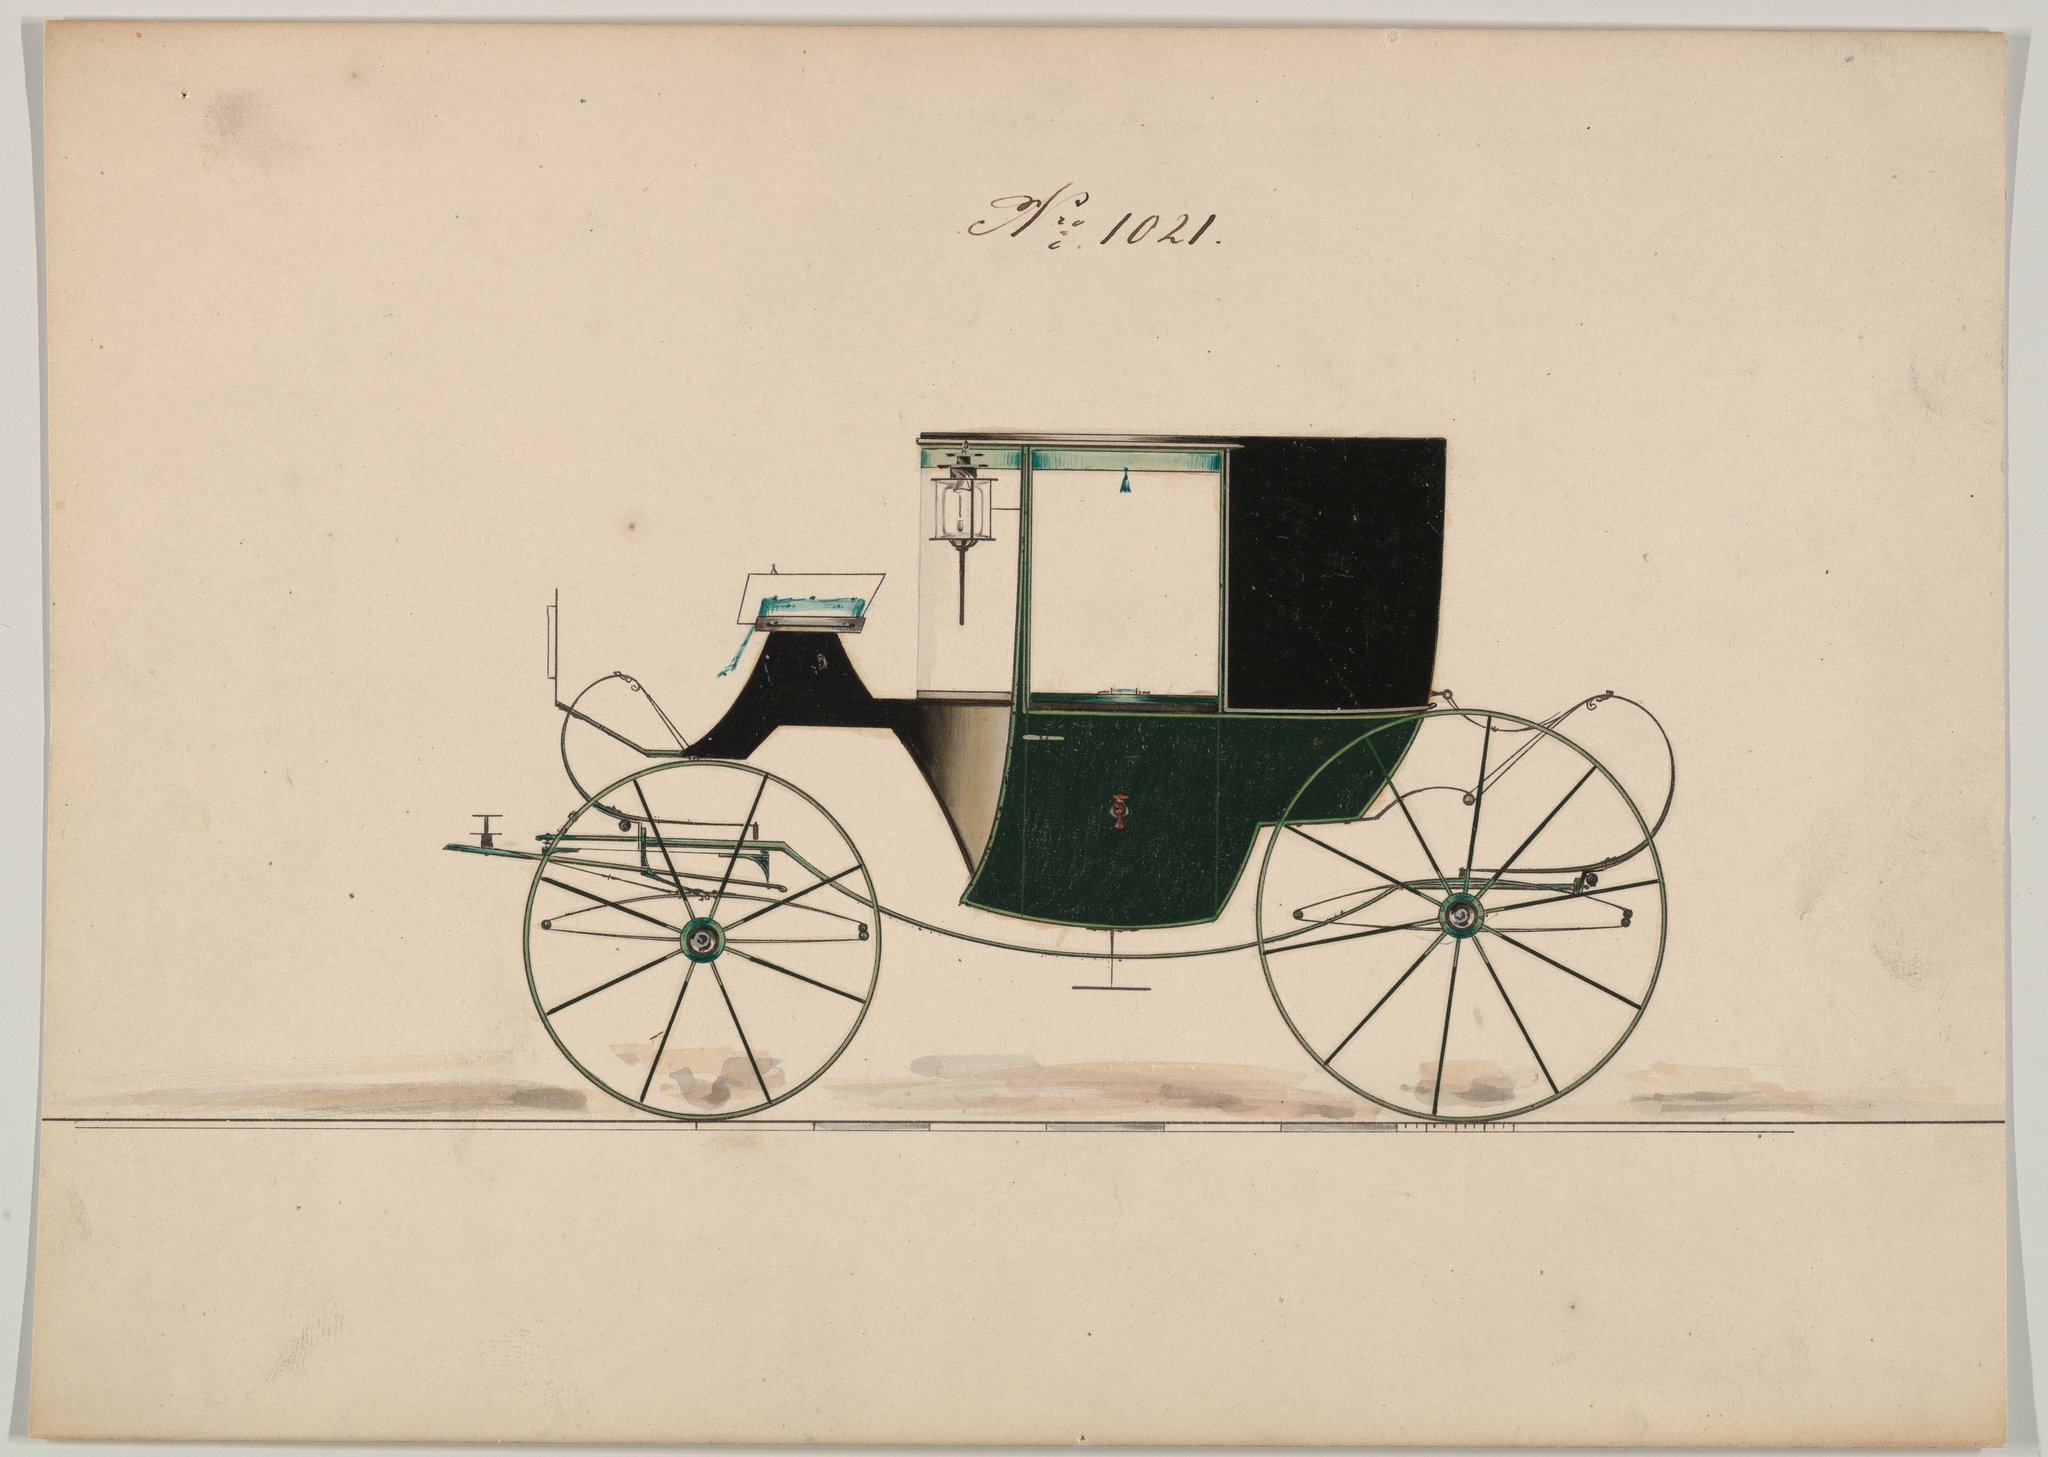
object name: drawing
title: Clarence #1021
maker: brewster & co.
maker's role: manufacturer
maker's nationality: american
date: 1850-1870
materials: gouache, gum arabic, ink, watercolor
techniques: pen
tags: carriages